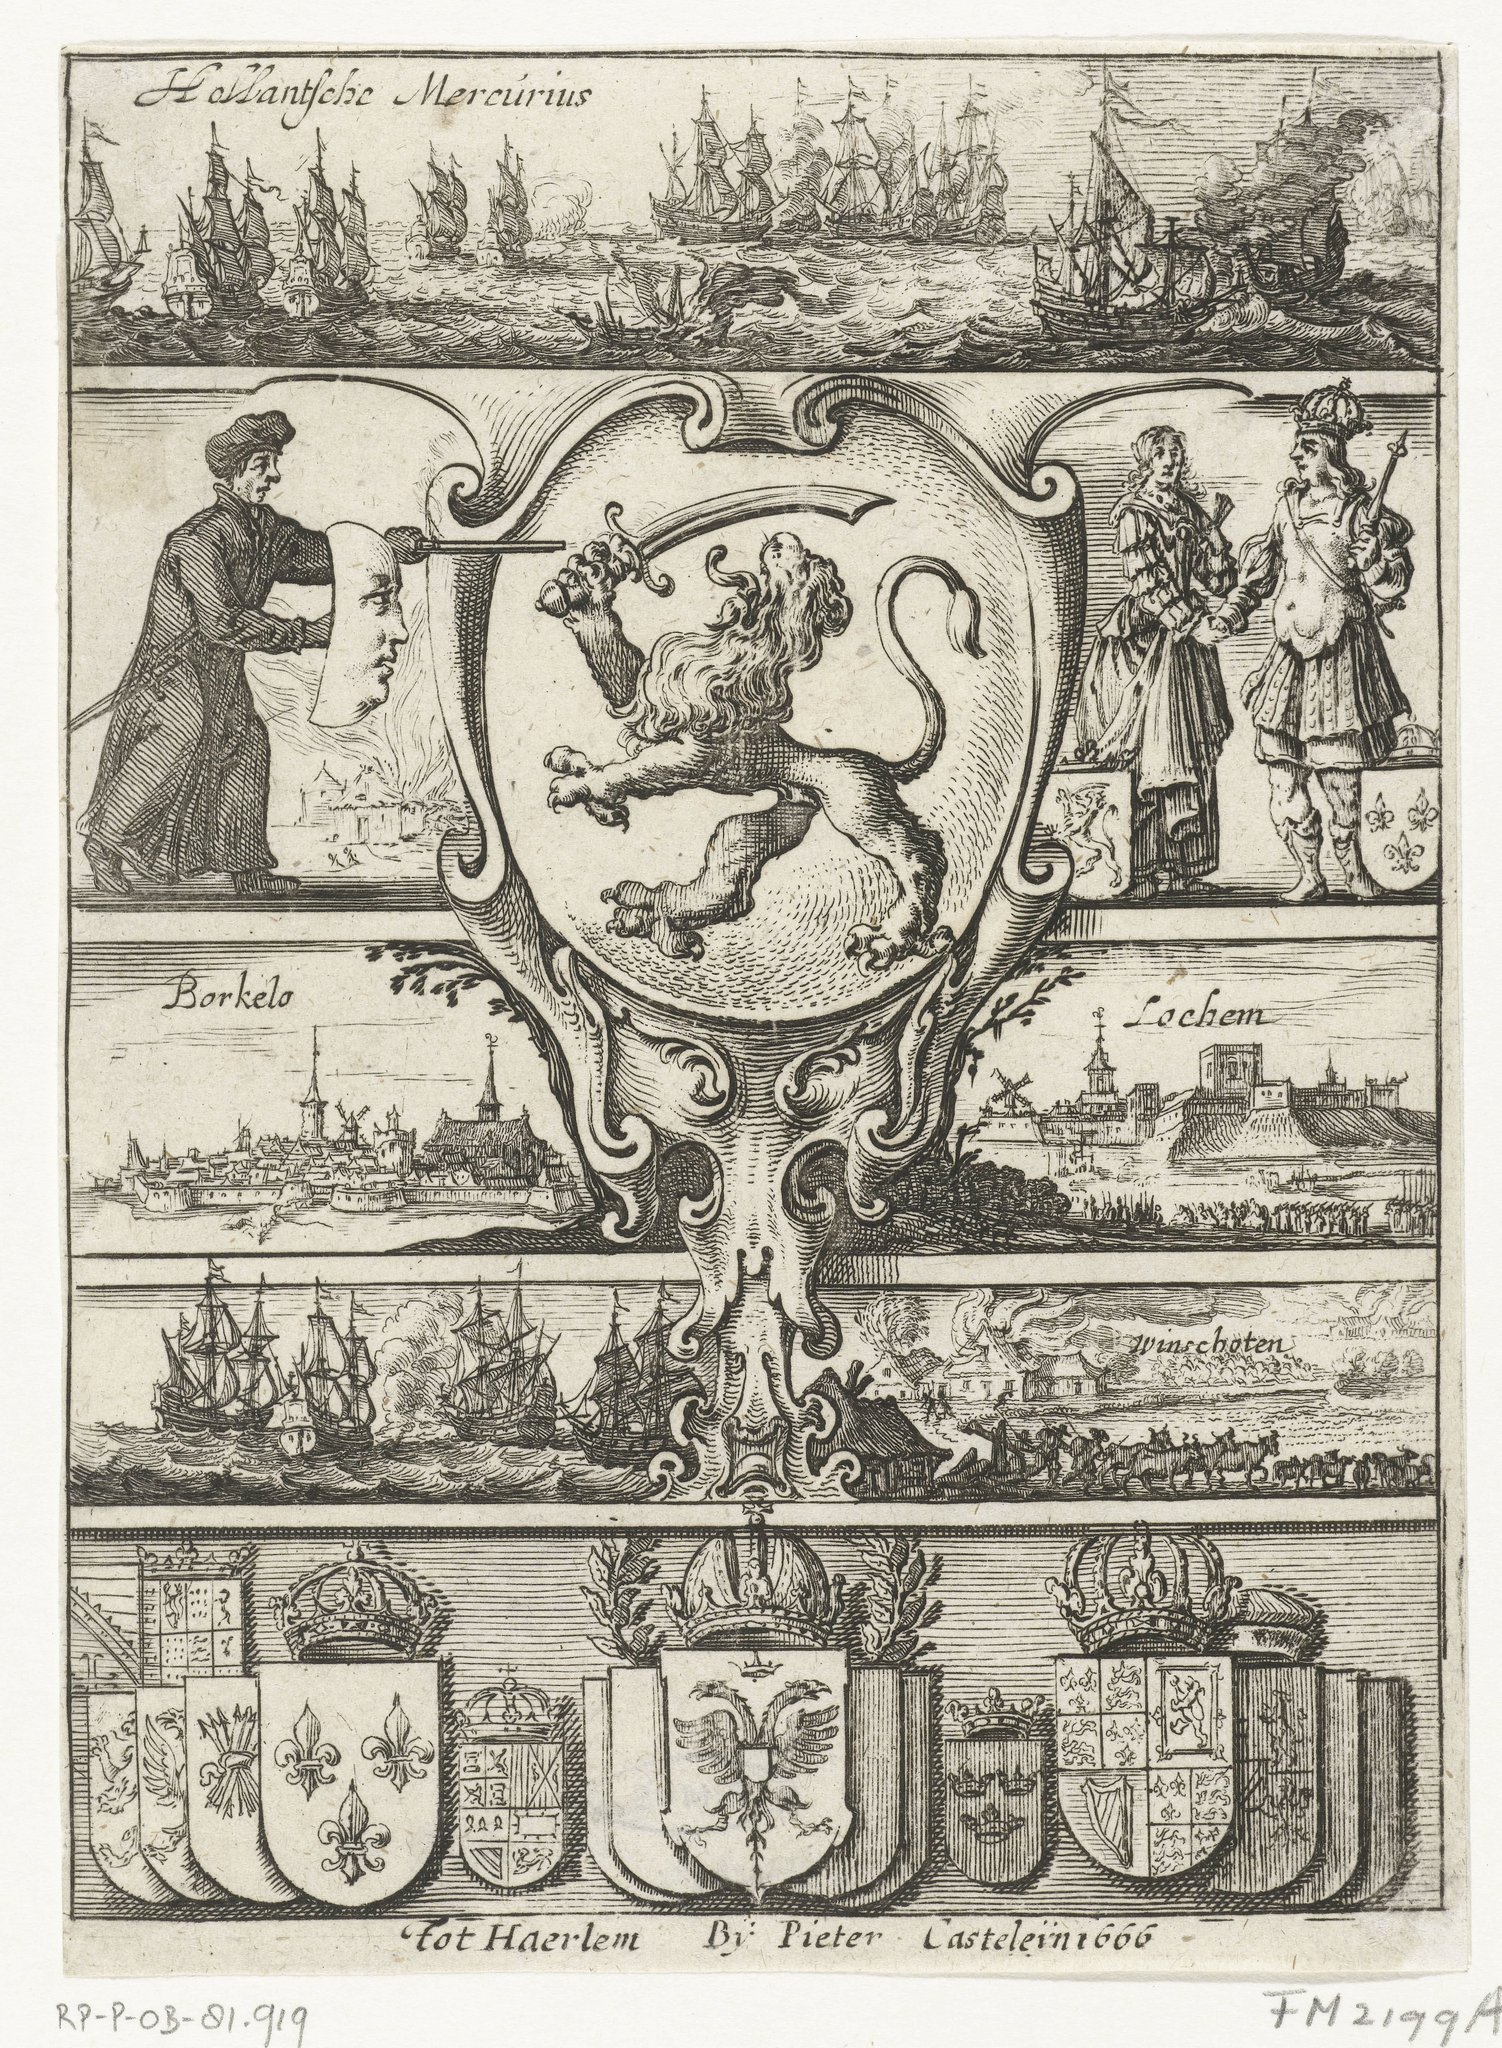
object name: print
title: Titelblad voor de Hollandsche Mercurius van het jaar 1665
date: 1666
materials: paper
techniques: etching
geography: northern netherlands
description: Titelblad voor de Hollandsche Mercurius van het jaar 1665 met centraal de Hollandse Leeuw. Hieromheen kleine scènes met gebeurtenissen uit het het jaar 1665, onder andere te Borculo, Lochem en Winschoten.